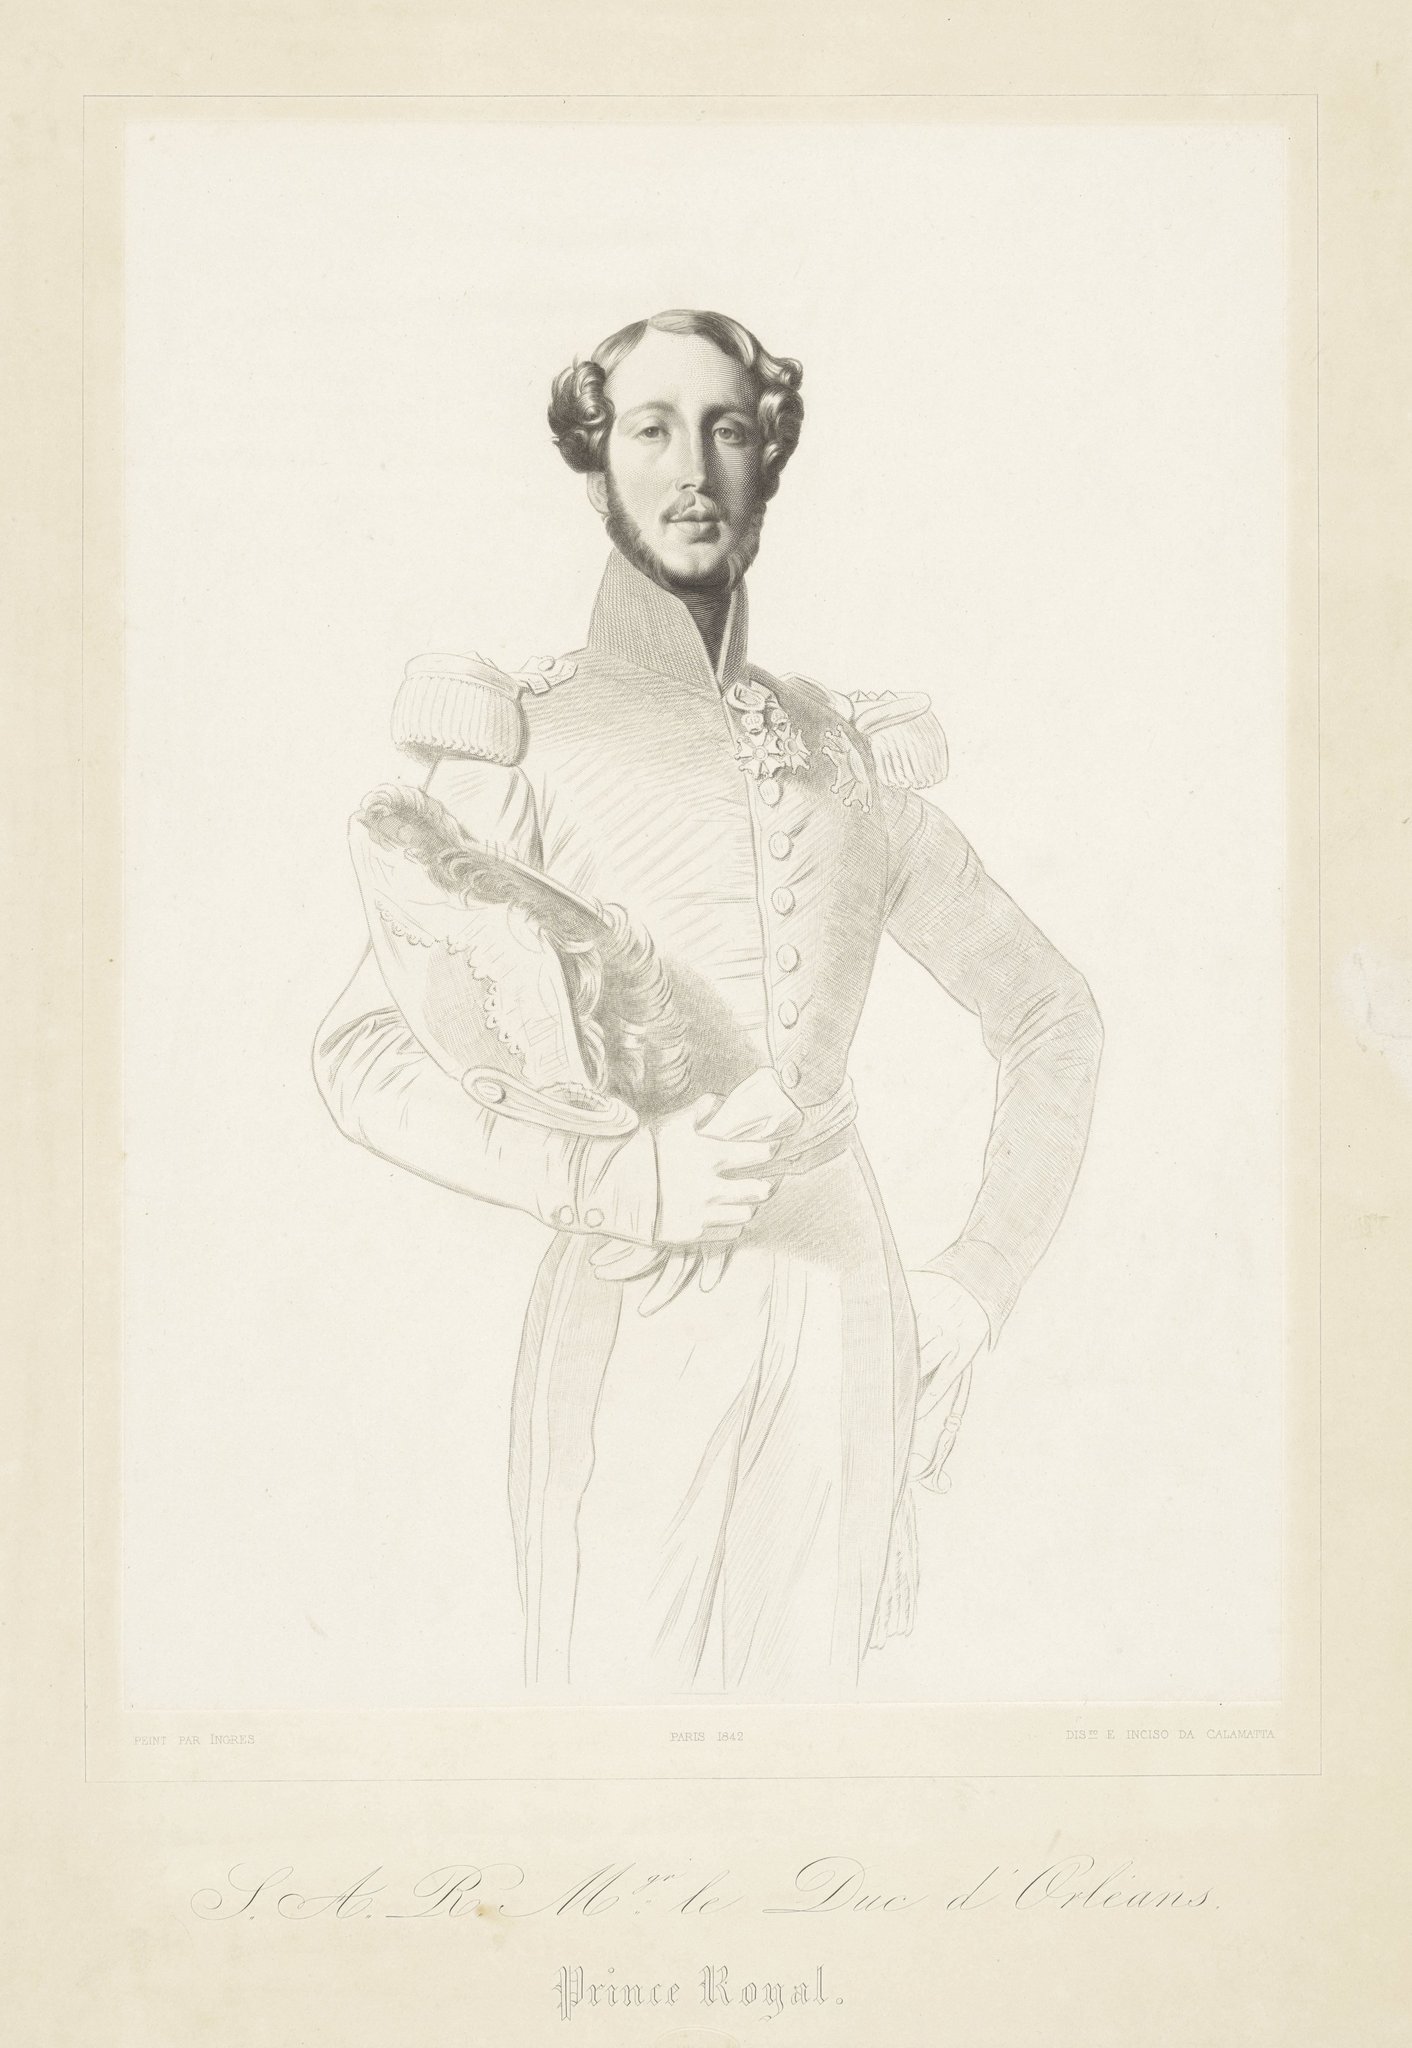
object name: print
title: Portret van Ferdinand Filips van Orléans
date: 1842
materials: paper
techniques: engraving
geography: paris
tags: historical persons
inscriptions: collector's mark: ‘Goupie & Vibeet / Editeurs [...]’, collector's mark: Lugt 2760, collector's mark: Lugt 2228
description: Naar een schilderij door Ingres dat zich bevindt in de Collection du Comte de Paris, Louveciennes, in Frankrijk.